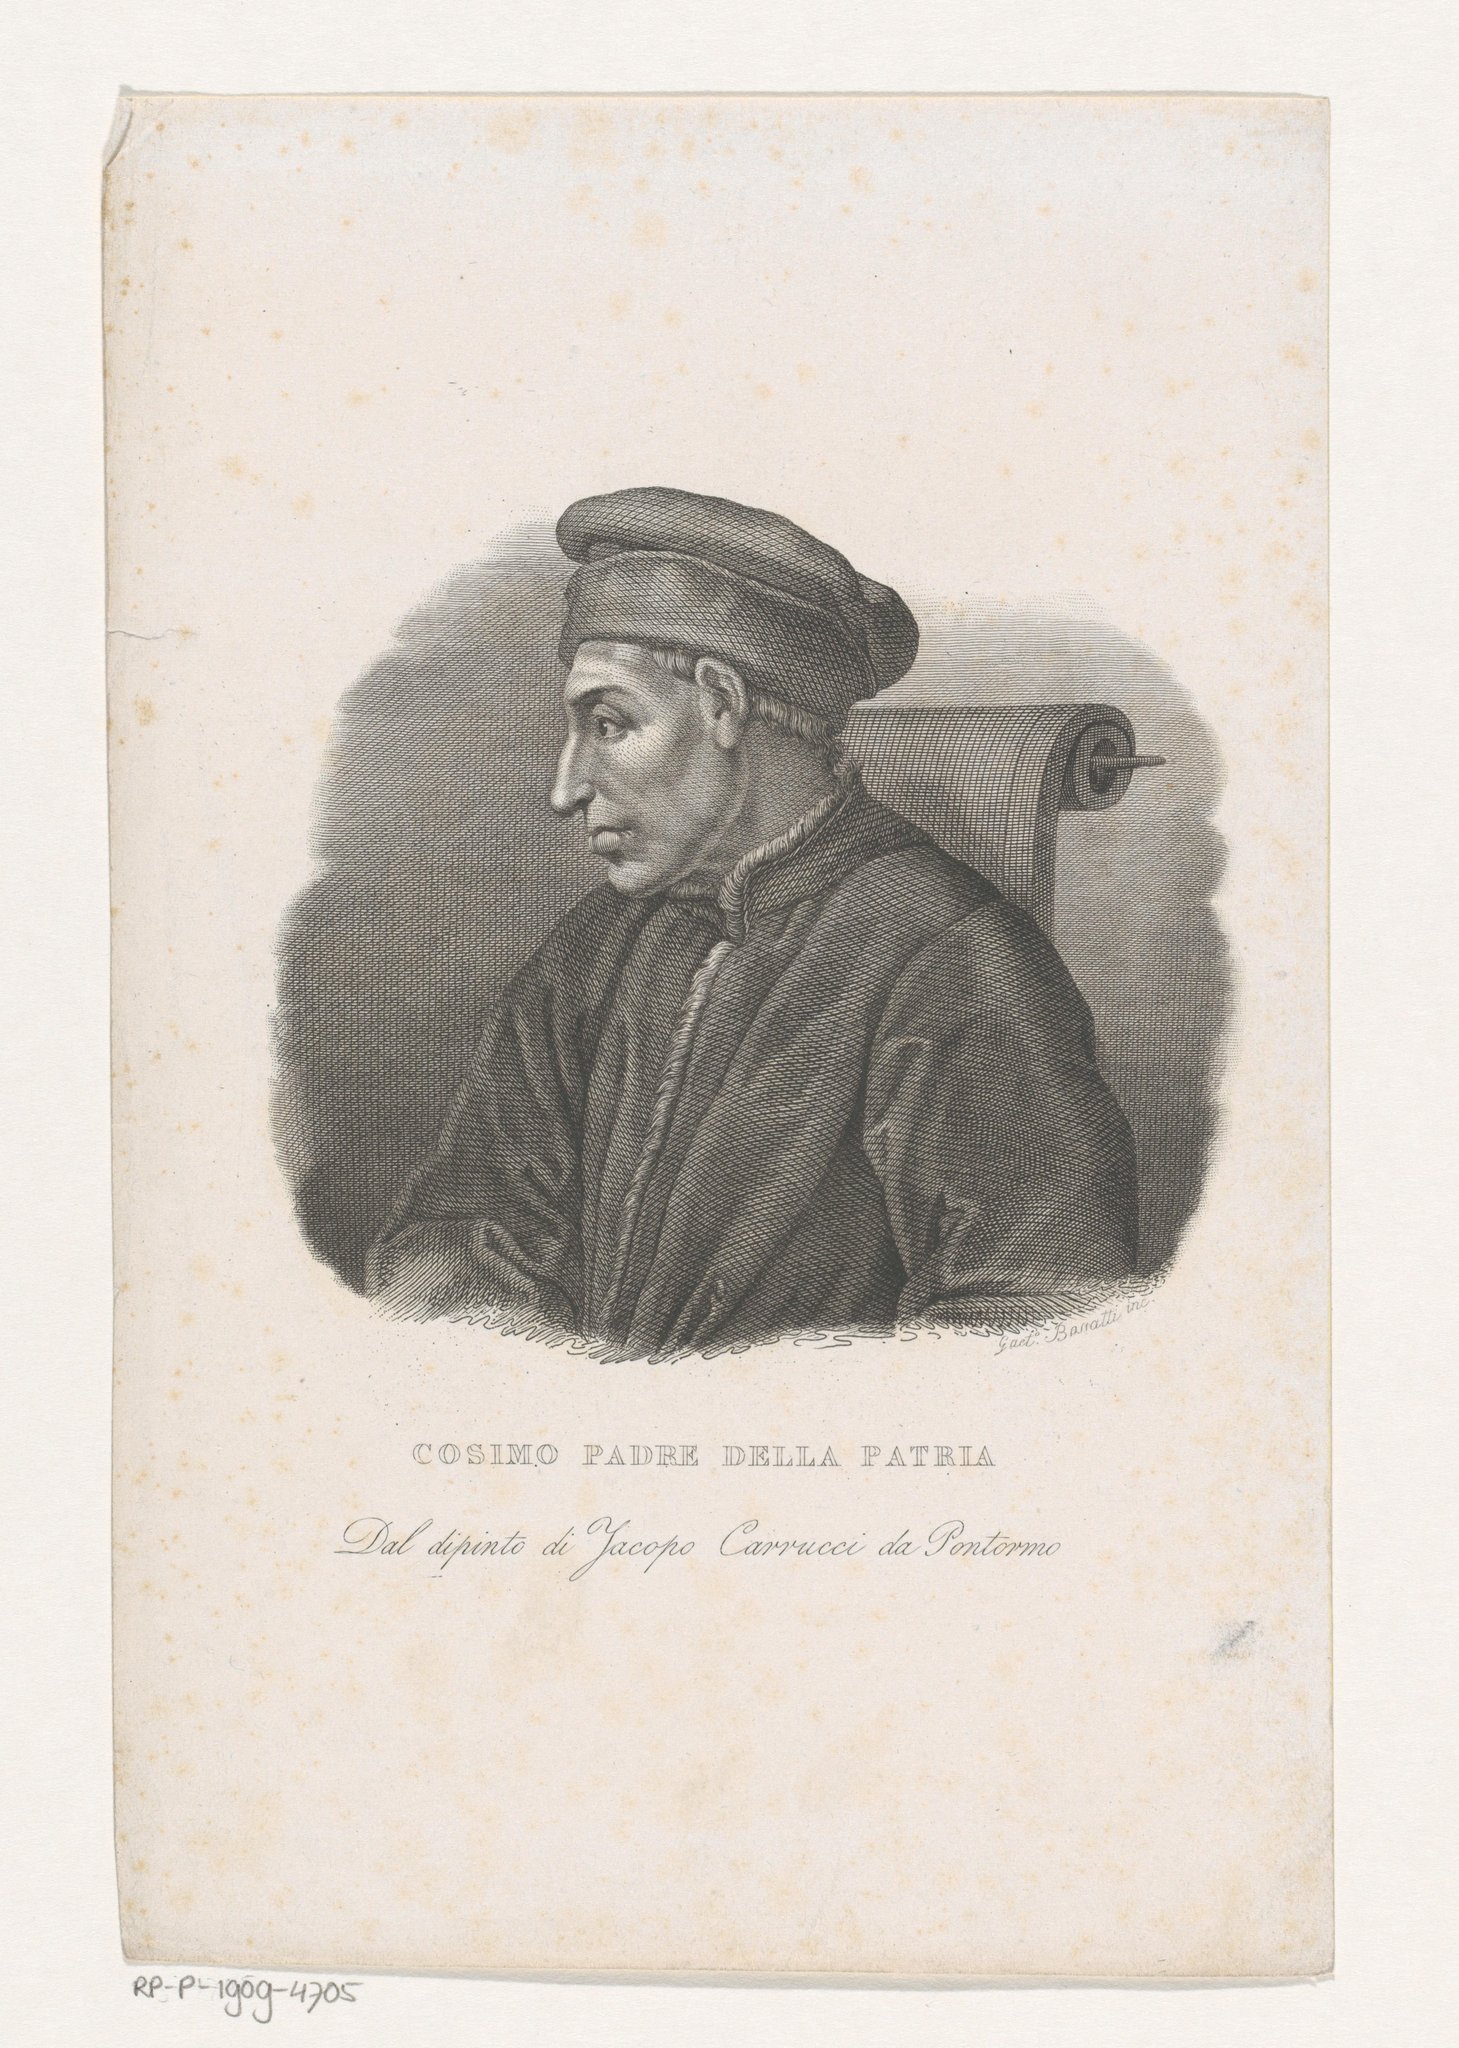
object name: print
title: Cosimo Padre delle Patria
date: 1800-1899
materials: paper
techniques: engraving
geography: italy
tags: politician, historical persons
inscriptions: collector's mark: Lugt 2228